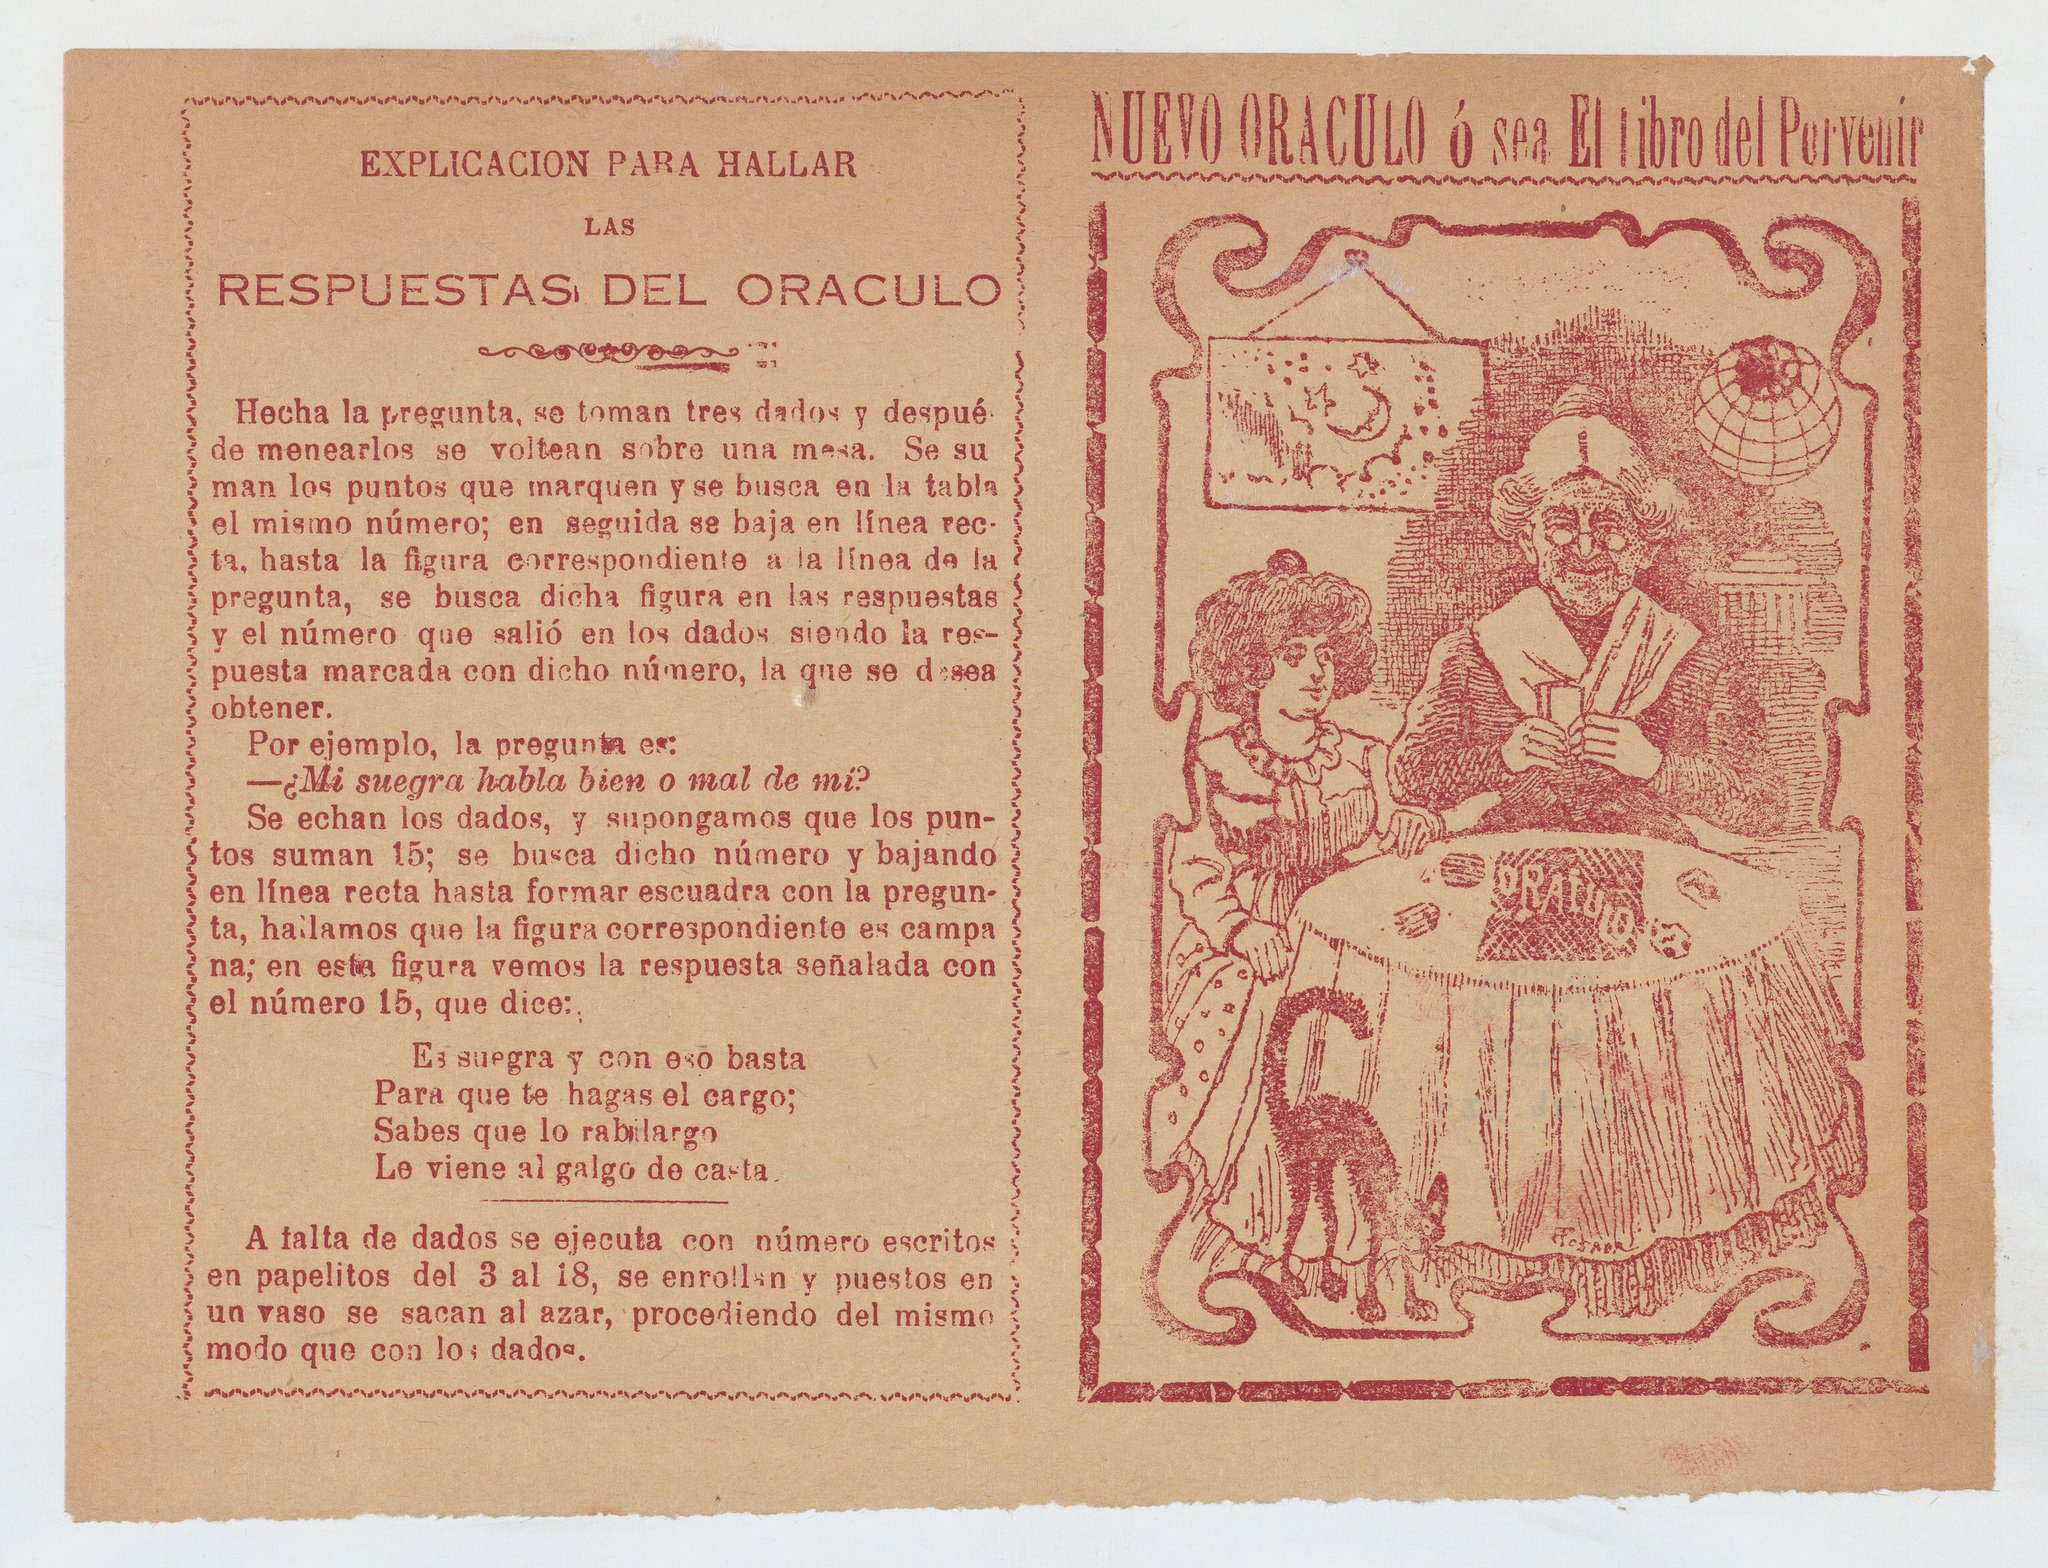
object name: print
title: Cover for 'Nuevo Oraculo ó sea El Libro del Porvenír', an old women seated at a table and reading someone's fortune from cards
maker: josé guadalupe posada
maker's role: artist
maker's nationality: mexican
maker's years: 1852-1913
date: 1880-1910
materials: ink, paper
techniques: letterpress, relief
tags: women,cats